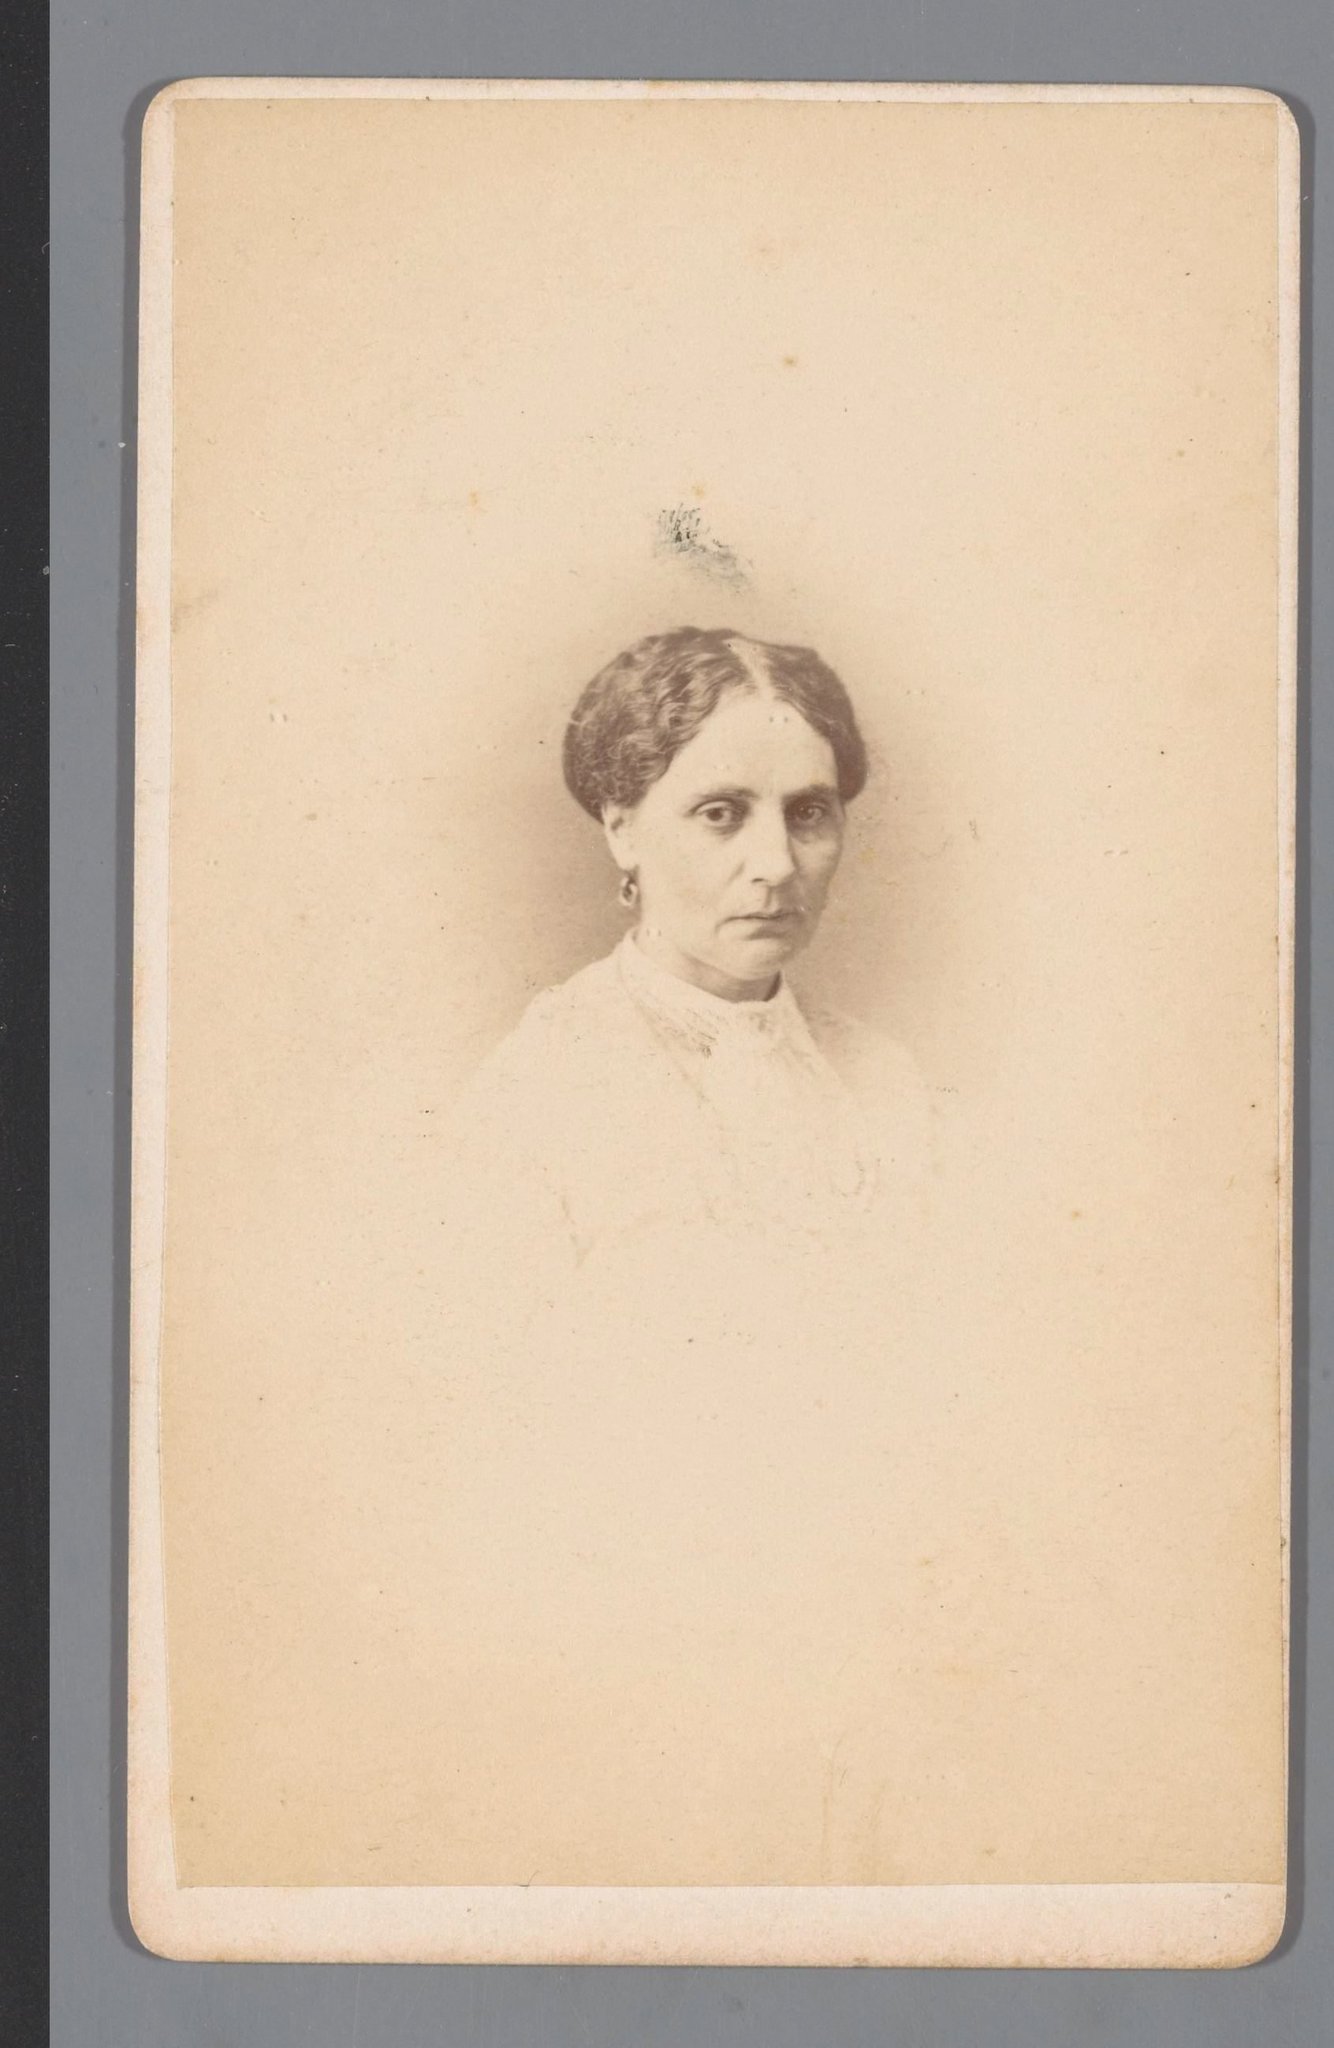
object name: carte de visite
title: Portret van een vrouw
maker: willem frederik vinkenbos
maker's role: fotograaf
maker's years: 1831-1896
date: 1867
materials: cardboard, paper, photographic support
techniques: albumen print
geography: the hague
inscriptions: address: ‘W.F.Vinkenbos/Photographe/s'Hage/21.Kerkstraat 21.’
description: Kop van een vrouw, naar rechts, zonder achtergrond.